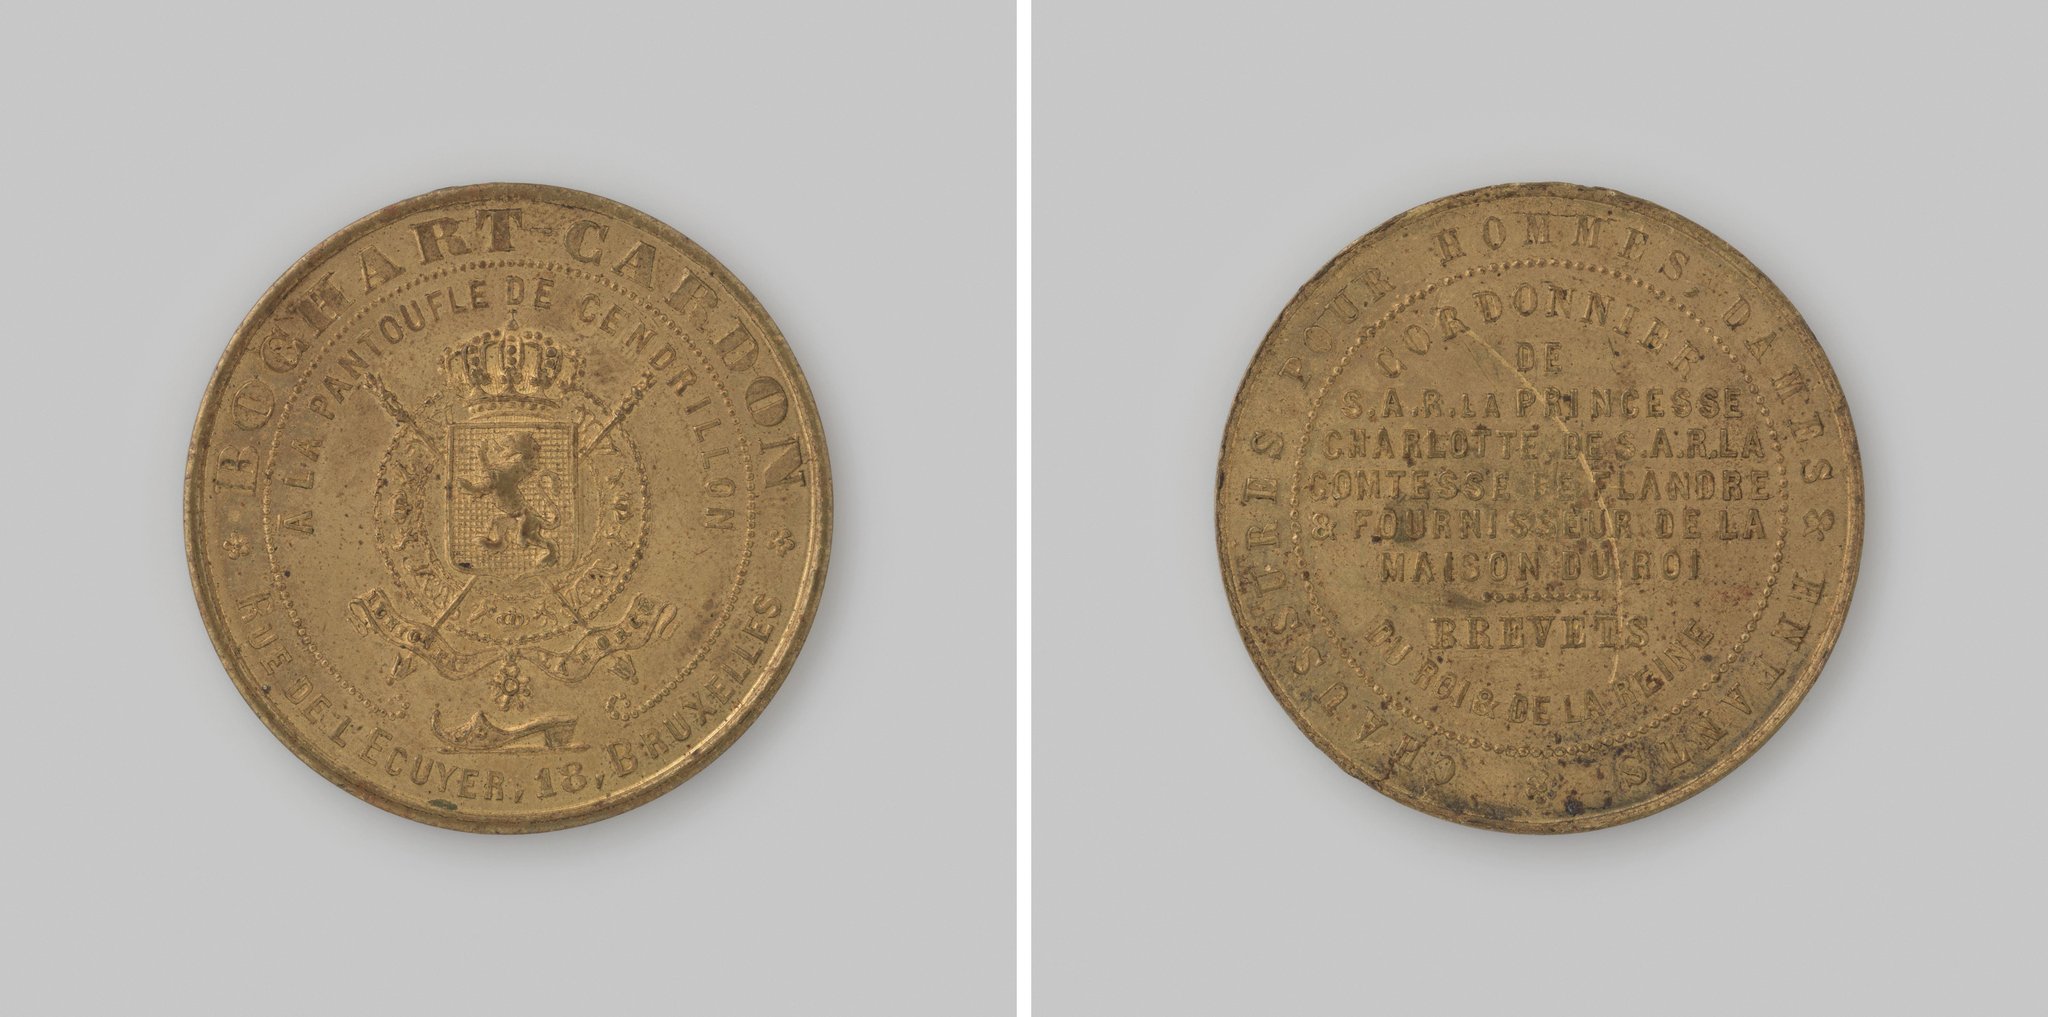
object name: history medal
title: Reclamepenning van schoenenwinkel Bochart-Cardon te Brussel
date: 1850-1900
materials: brass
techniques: striking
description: Messing penning, op de voorzijde het gekroonde Belgische wapenschild met ordeteken, gekruiste scepters en banderol boven een damesmuiltje, met dubbel omschrift, op de keerzijde negen regels tekst, met omschrift.